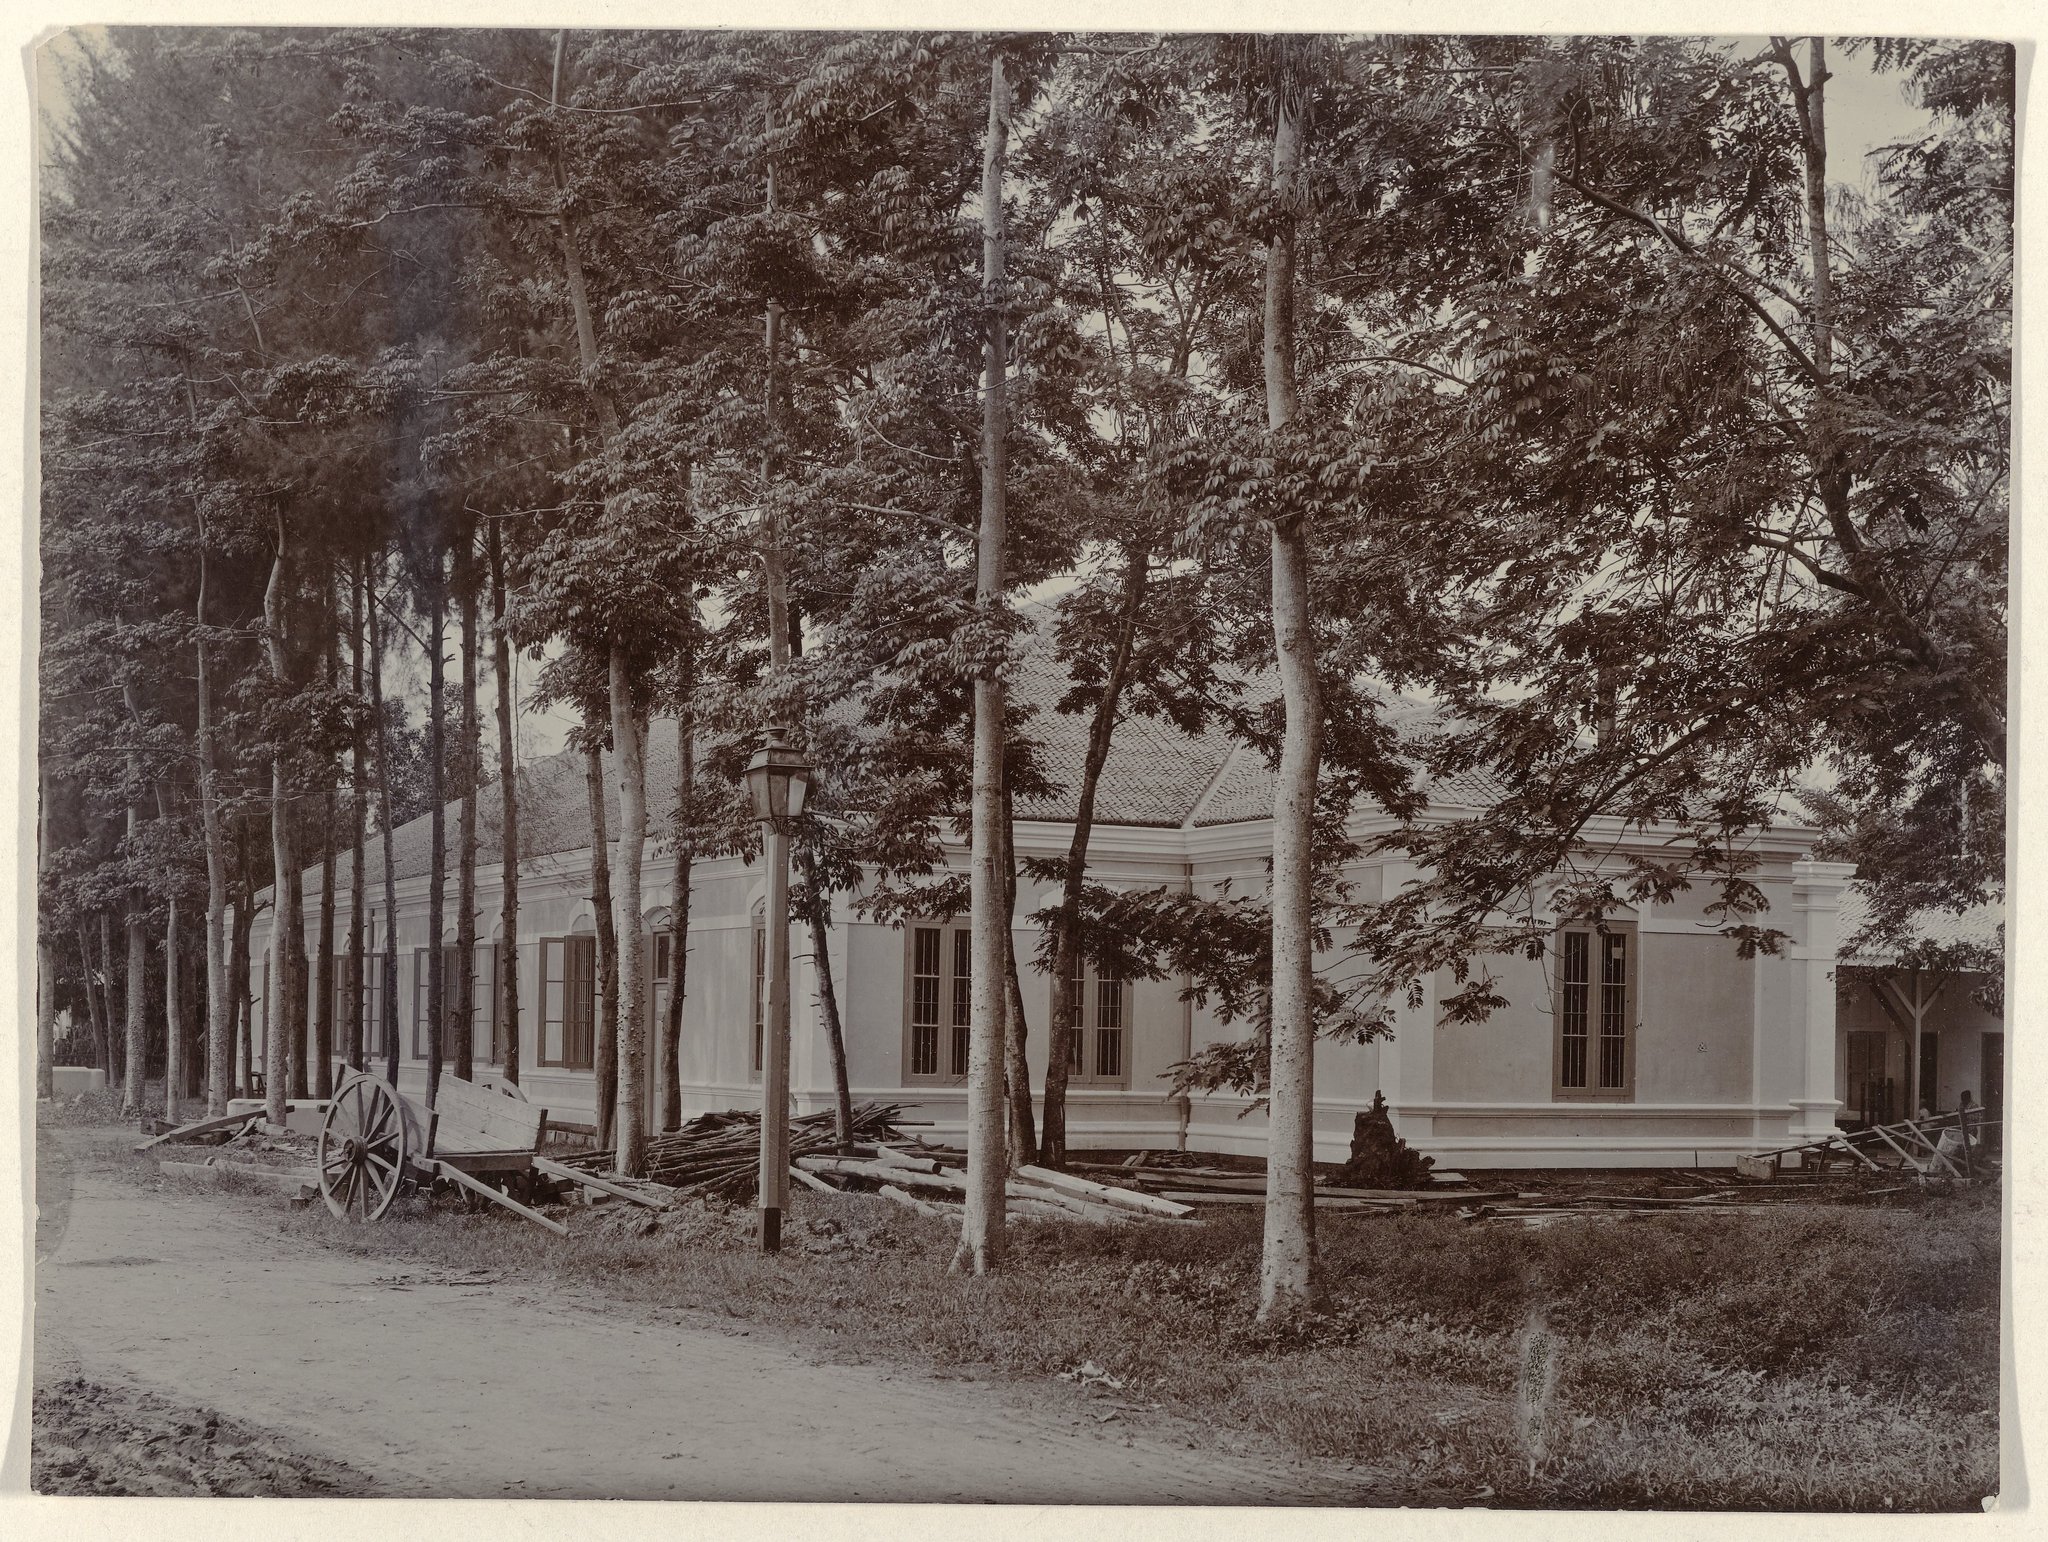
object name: photograph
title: Drukkerij van de Deli Courant te Medan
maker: Anonymous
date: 1809-1898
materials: photographic support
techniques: collodion silver print, gelatin silver print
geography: medan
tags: dutch east indies, the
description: Gezicht op het nieuwe gebouw voor de drukkerij van de Deli Courant te Medan. Onderdeel van een groep van 8 foto's uit september 1898 binnen de groep van 49 losse zwart-wit foto's van verschillend formaat over de uitgeverij en drukkerij van de krant Deli Courant in Medan in de periode 1885-1947.